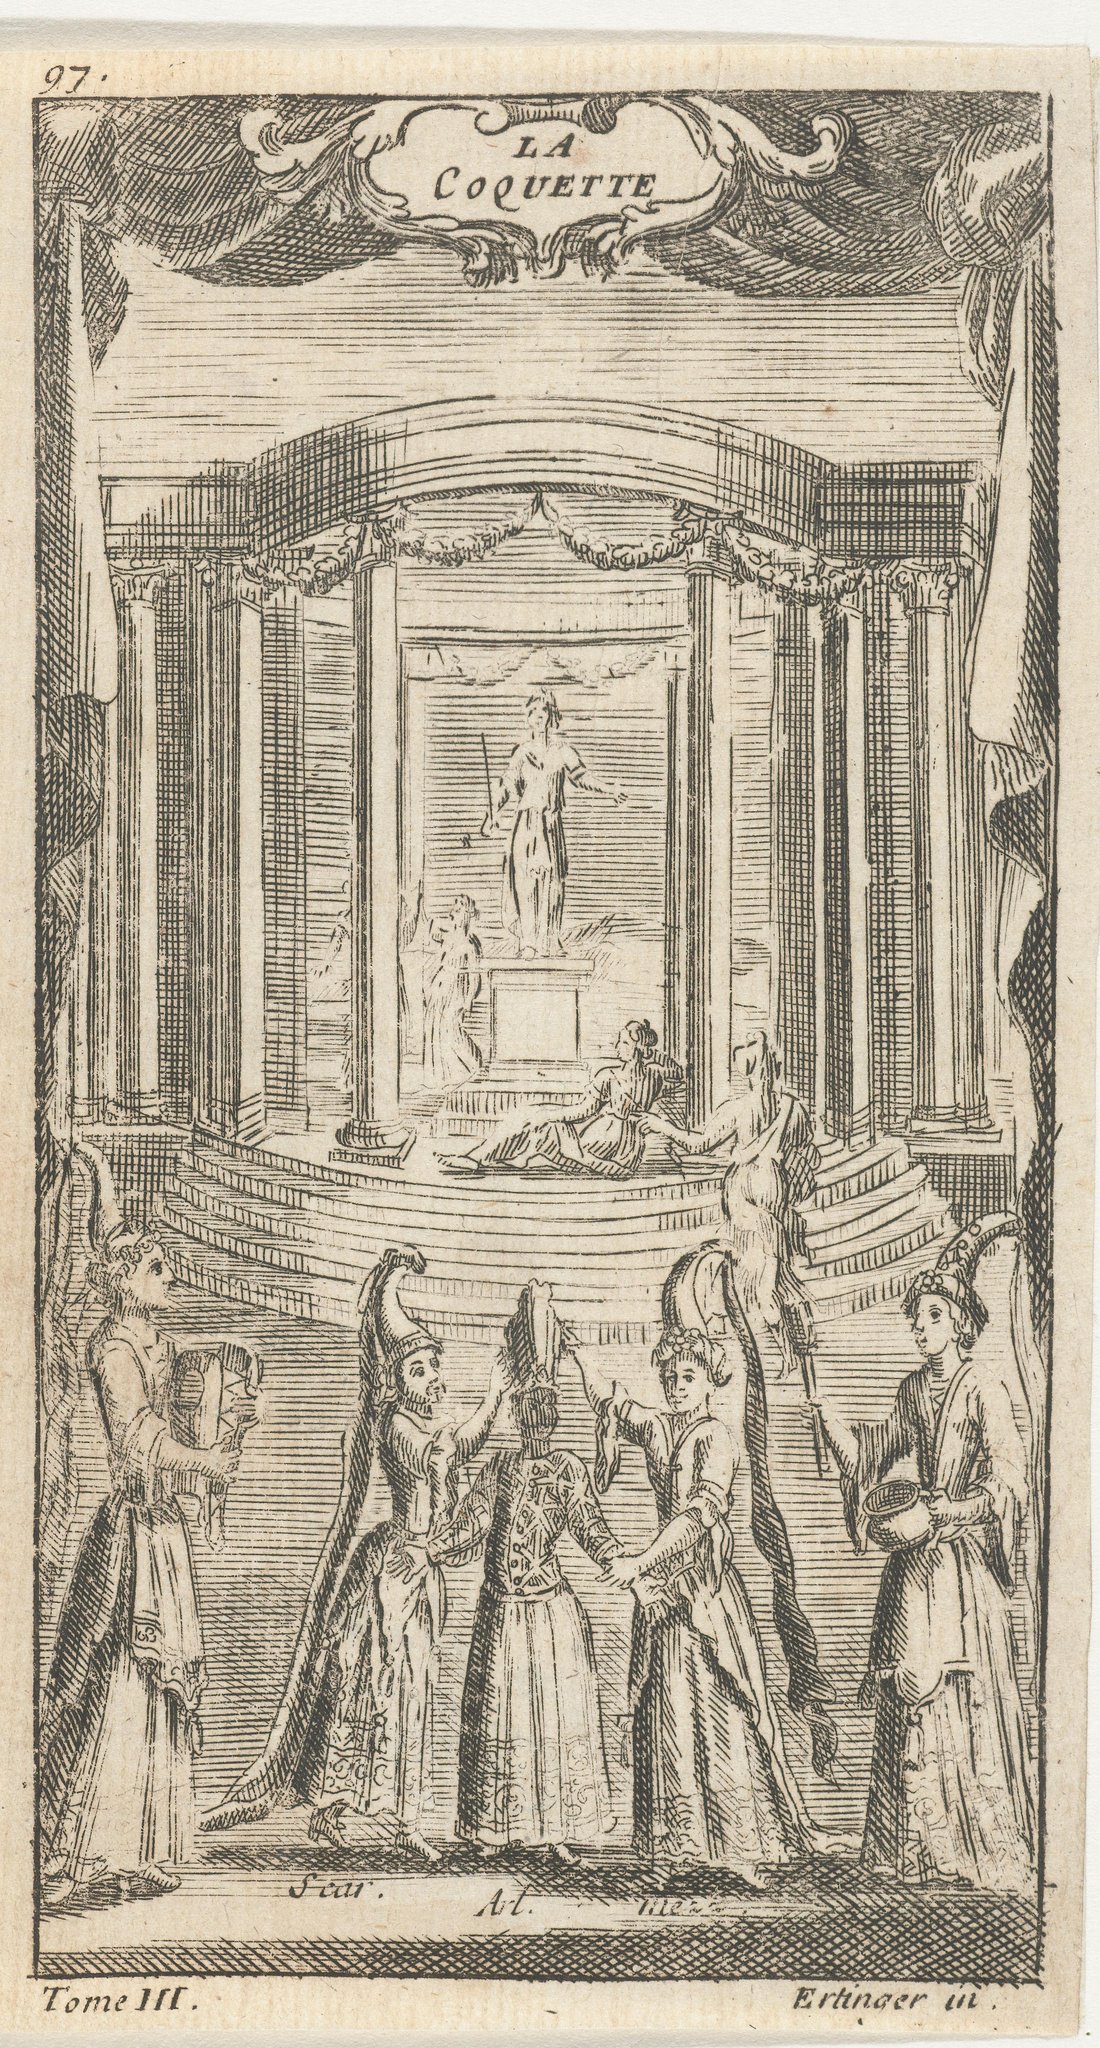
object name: titelblad, titelpagina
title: Titelpagina voor La Coquette, in Le Théâtre Italien de Gherardi, Parijs 1700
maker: franz ertinger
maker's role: print maker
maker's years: 1640-1710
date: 1694-1700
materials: paper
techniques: etching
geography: paris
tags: 'commedia dell'arte'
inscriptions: collector's mark: Lugt 2228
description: Scène uit een toneelstuk. Vijf hofdames met hoge punthoeden. Op de achtergrond een halfrond gebouw met standbeeld op sokkel. Linksboven het nummer 97. Titelpagina voor het toneelstuk La Coquette ou l'académie des dames, van Jean-François Regnard, uitgegeven in Le Théâtre Italien de Gherardi, van Evaristo Gherardi in 1700.